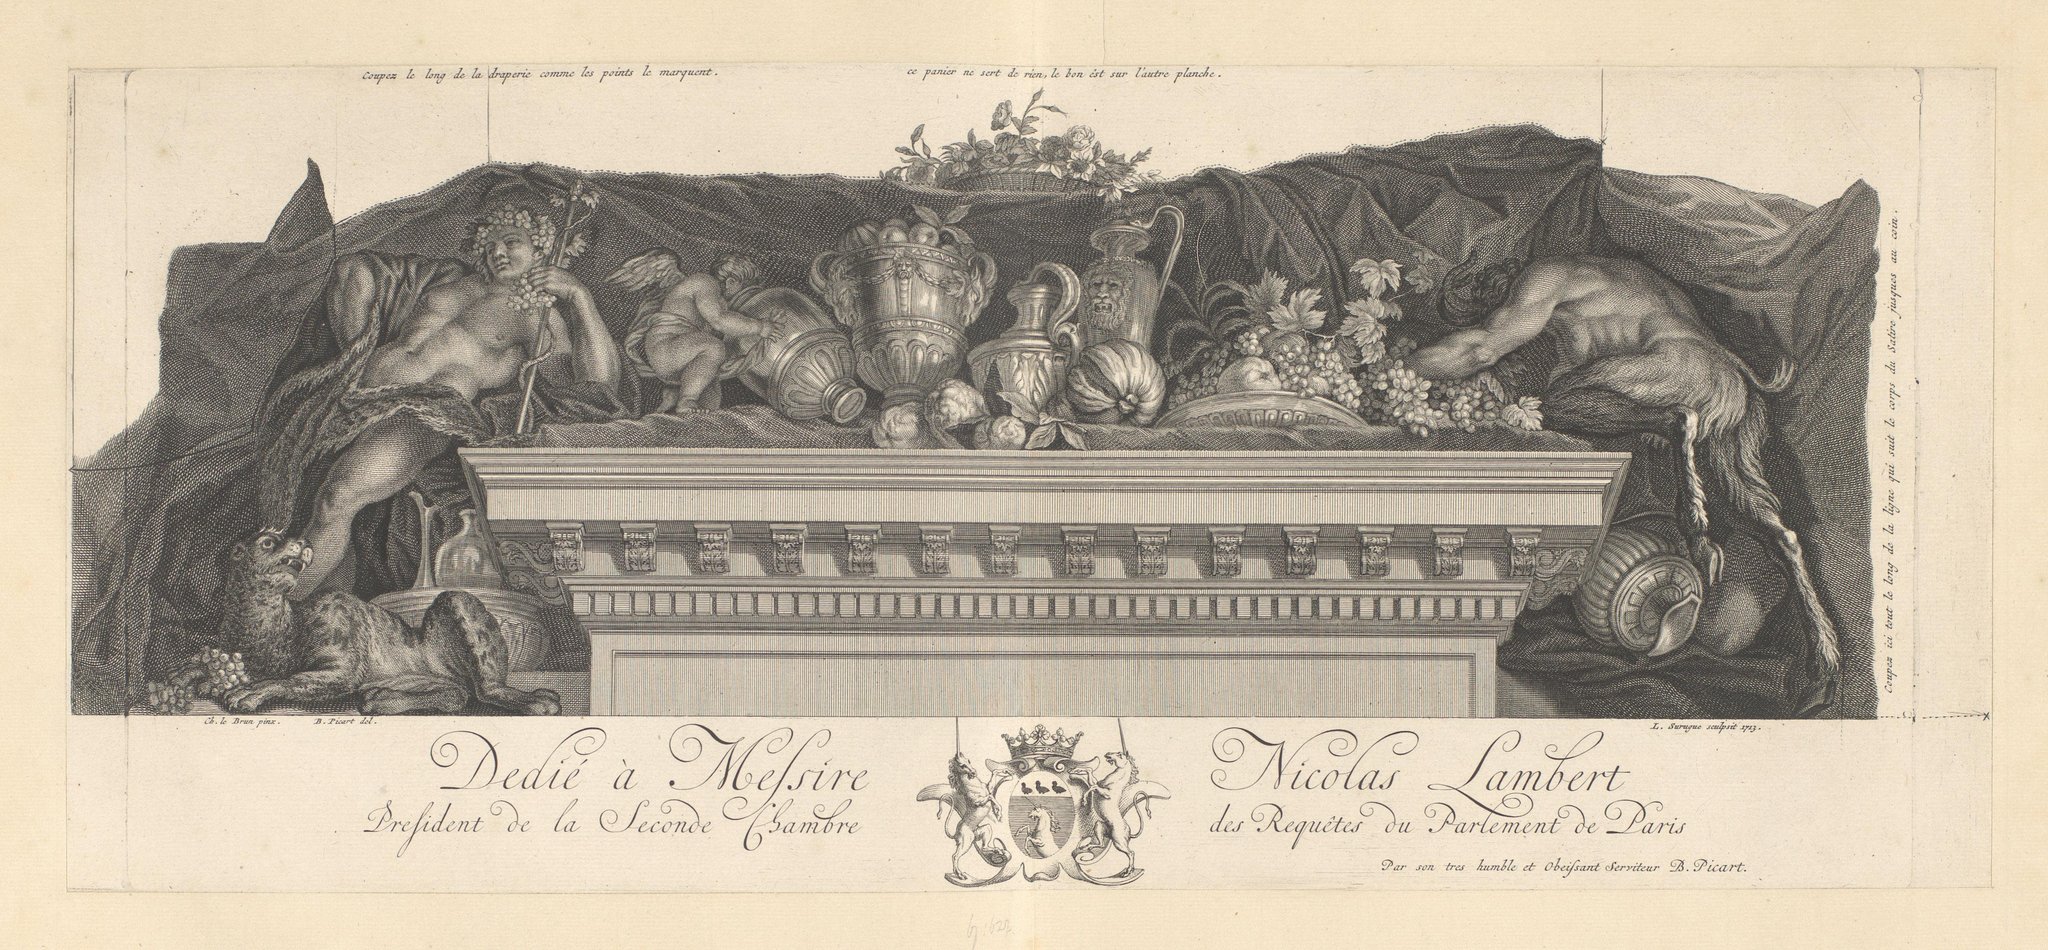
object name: print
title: Kroonlijst geflankeerd door Bacchus en Pan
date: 1713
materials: paper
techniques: engraving, etching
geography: amsterdam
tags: (story of) bacchus (dionysus), liber, satyr(s) (in general), (decorated) ceiling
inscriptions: date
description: Kroonlijst geflankeerd door Bacchus, met de thyrsus in zijn hand, en Pan, op de rug gezien. Langs de randen instructies voor het monteren van de prent aan andere prenten. Onderaan een opdracht in het Frans aan Nicolas Lambert en in het midden zijn wapenschild. Deze prent maakt deel uit van een album.